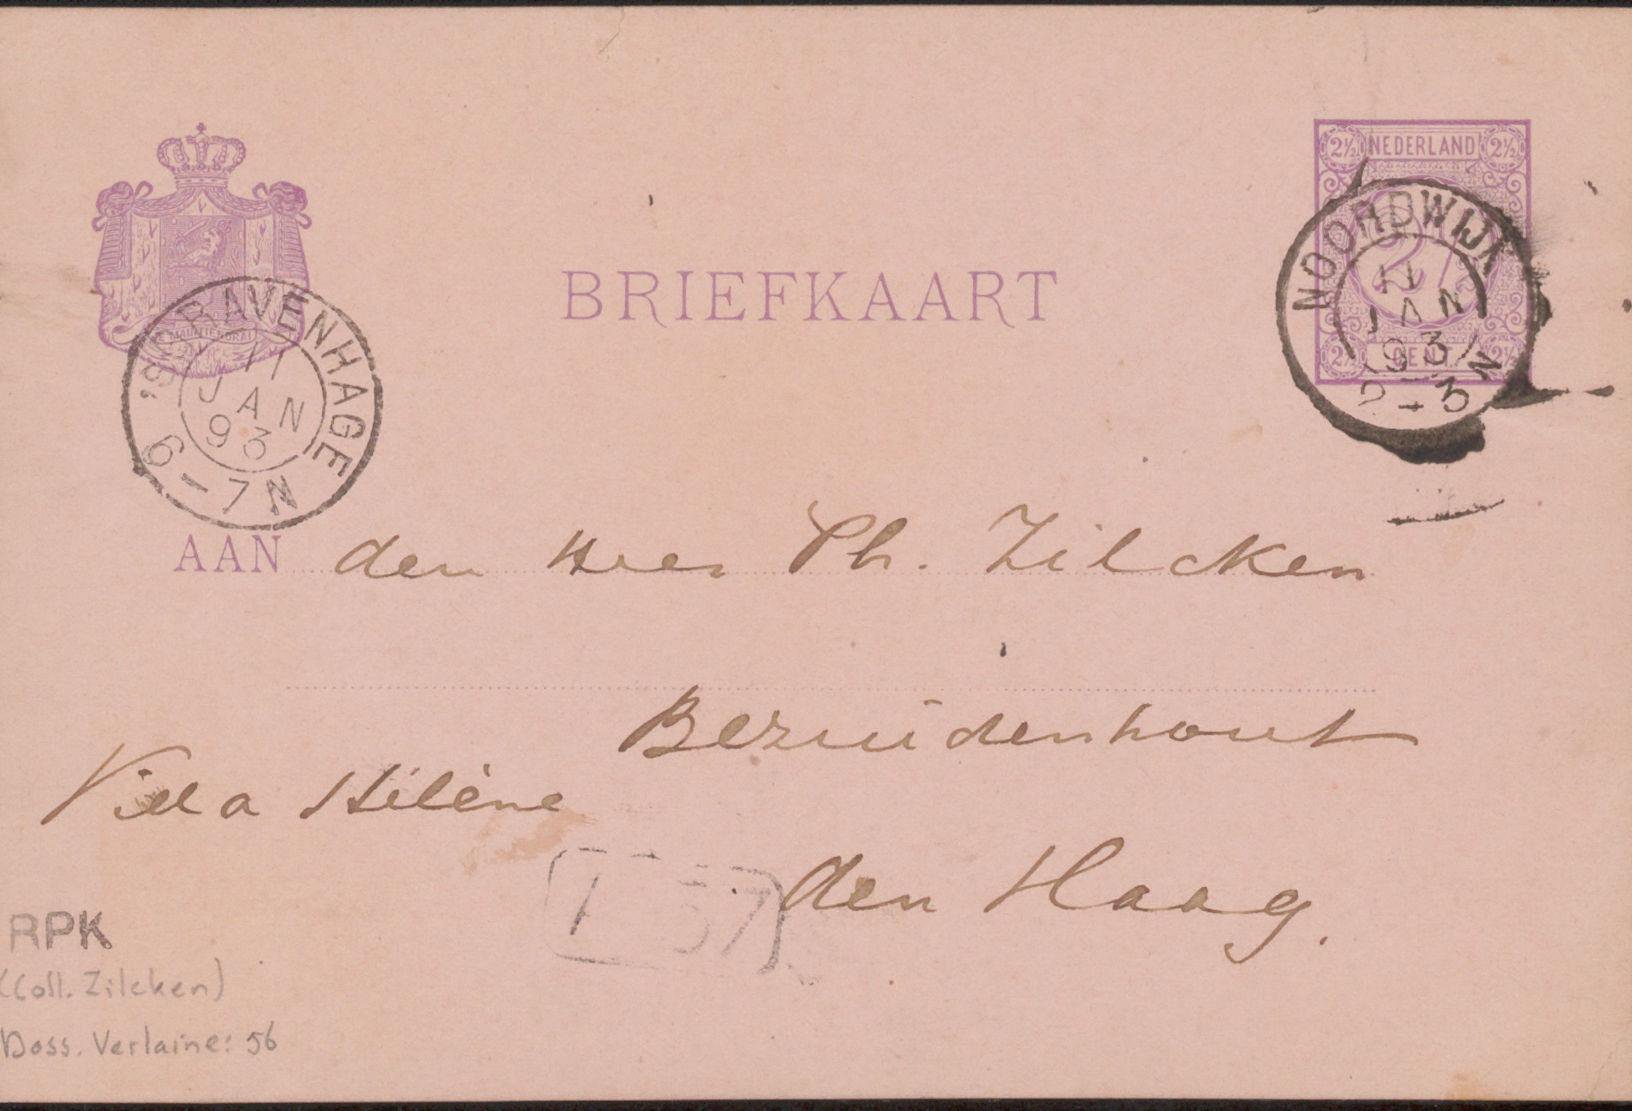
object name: postcard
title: Briefkaart aan Philip Zilcken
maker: albert verwey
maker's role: criticus, dichter, essayist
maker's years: 1865-1937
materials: cardboard, ink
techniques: pen, writing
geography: noordwijk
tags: frans erens, the hague, painter, draughtsman, philip zilcken, literature ~ arts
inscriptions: collector's mark: ‘RPK’